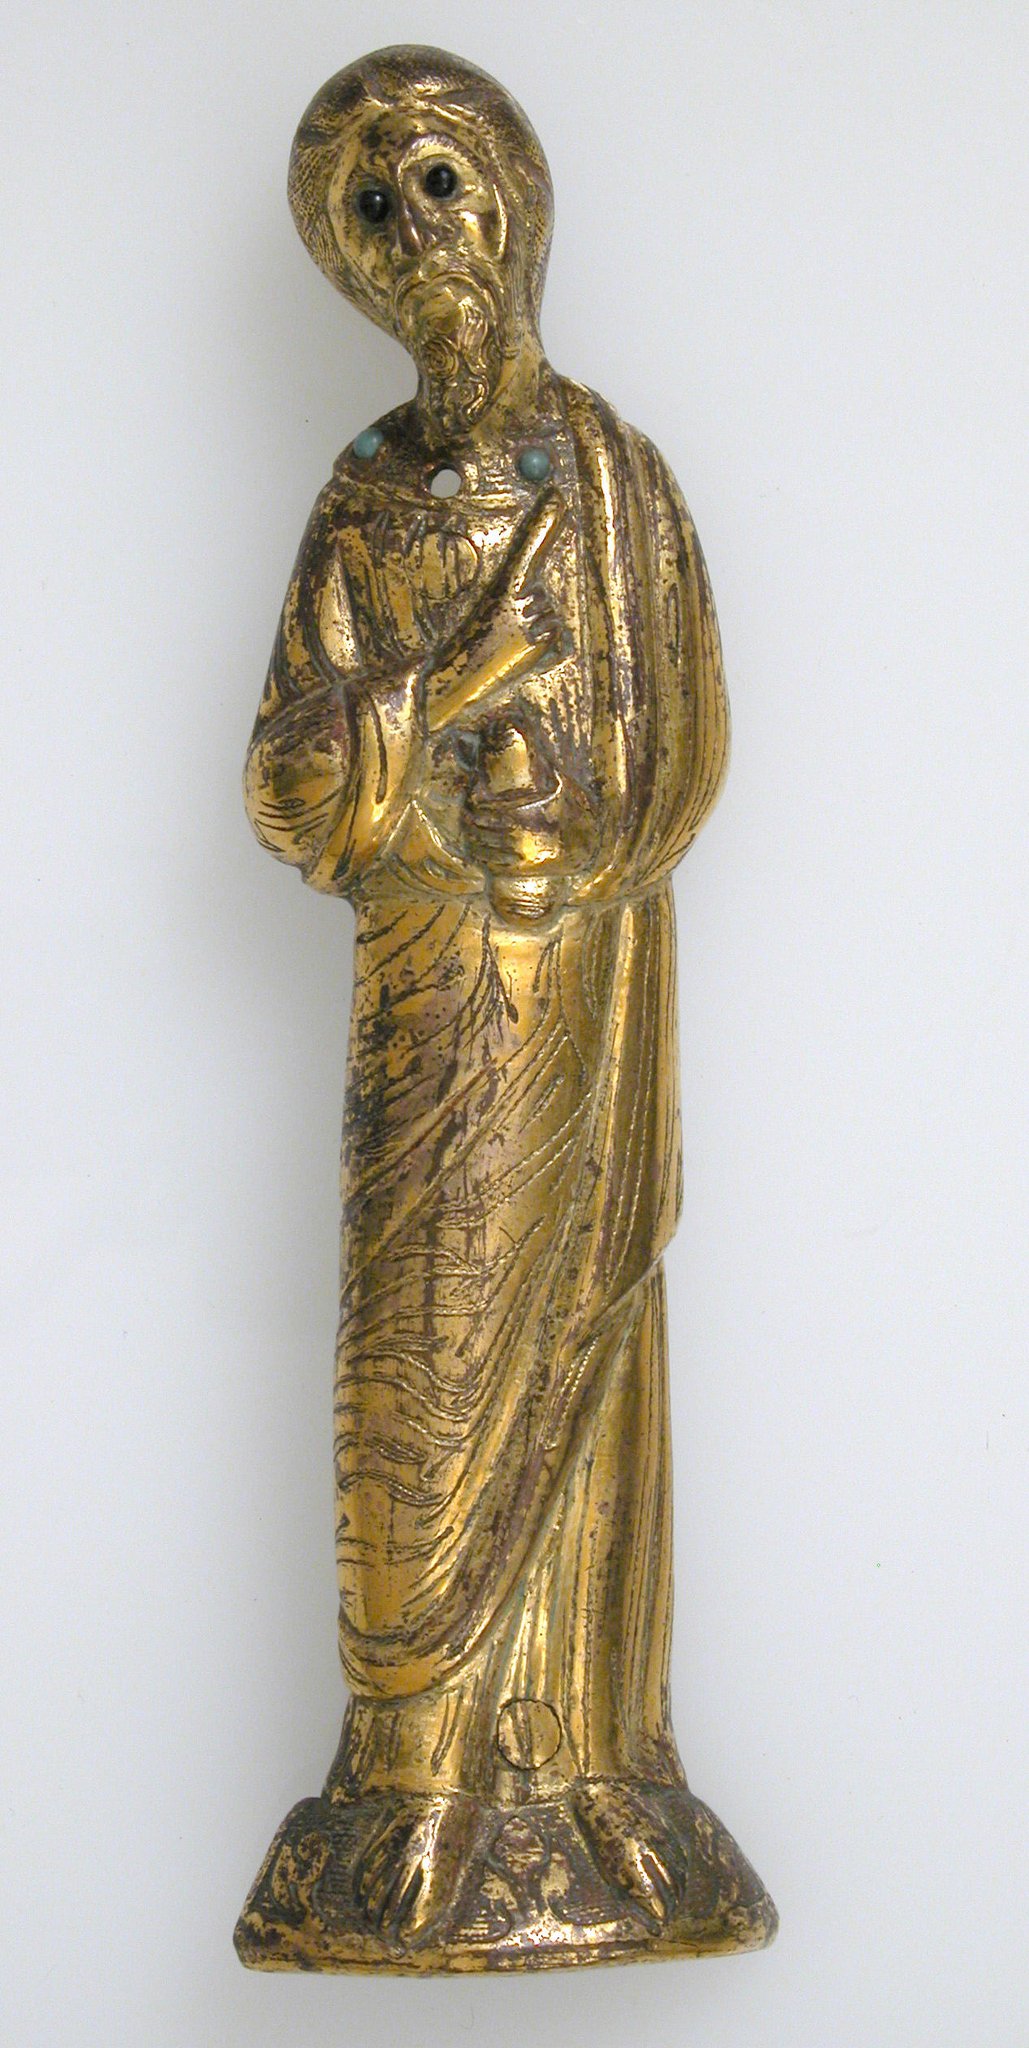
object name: appliqué figure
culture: french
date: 1220-1240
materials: copper, gilt, glass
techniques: chasing, engraving, repoussé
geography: france